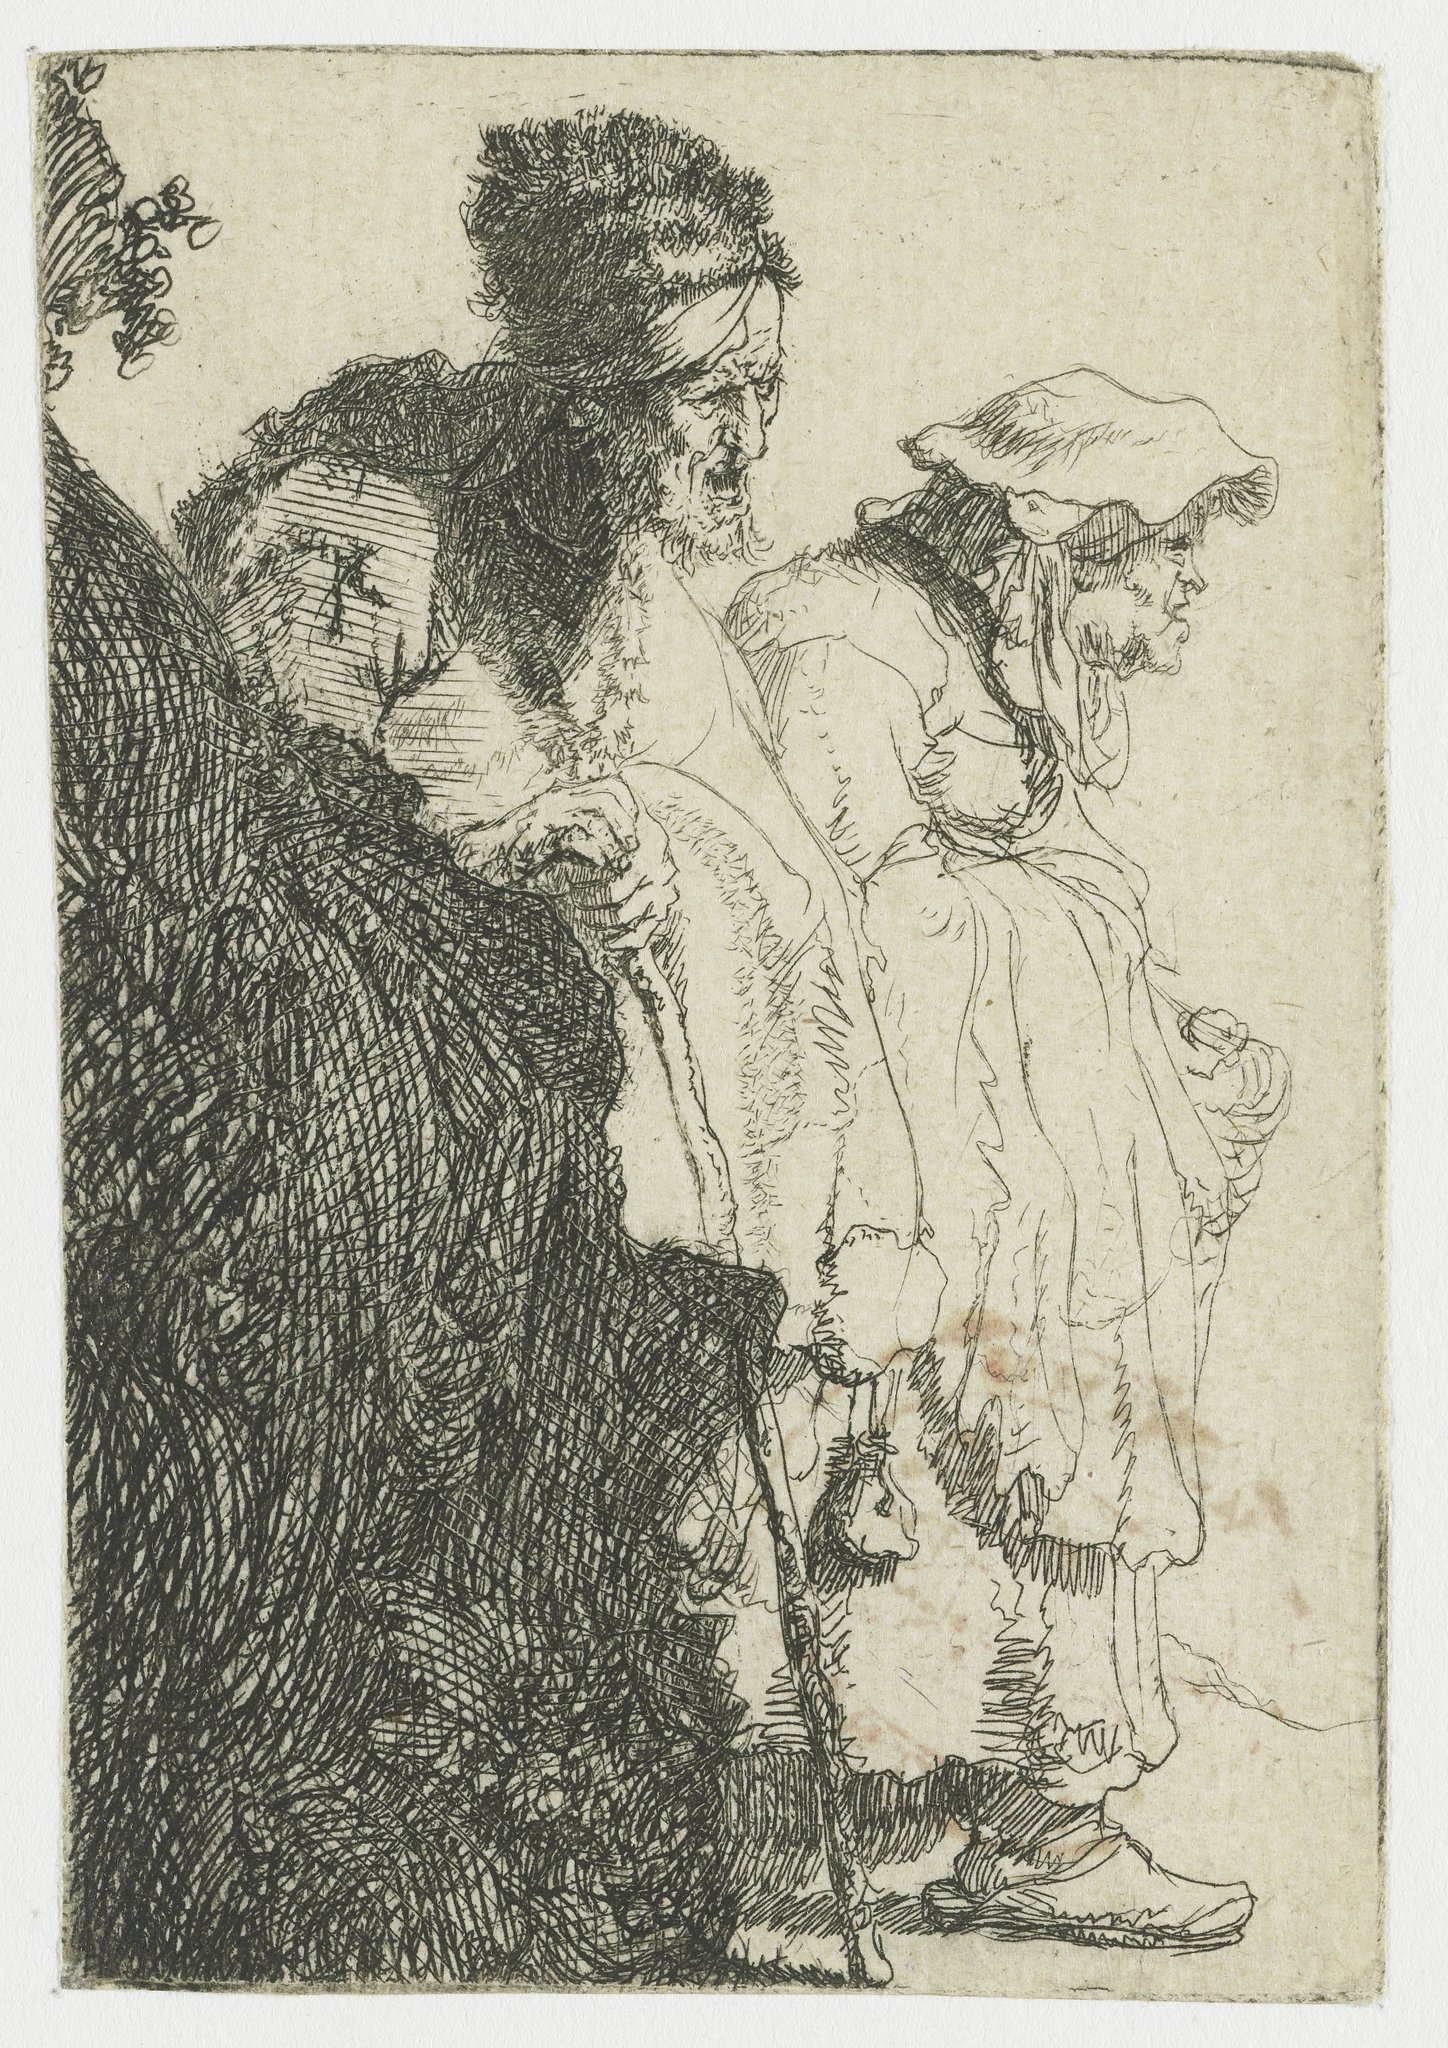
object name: print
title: Beggar man and woman behind a bank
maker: rembrandt van rijn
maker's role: draughtsman, painter, print maker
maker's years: 1606-1669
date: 1630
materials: paper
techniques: drypoint, etching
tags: beggar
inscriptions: collector's mark: Lugt 240